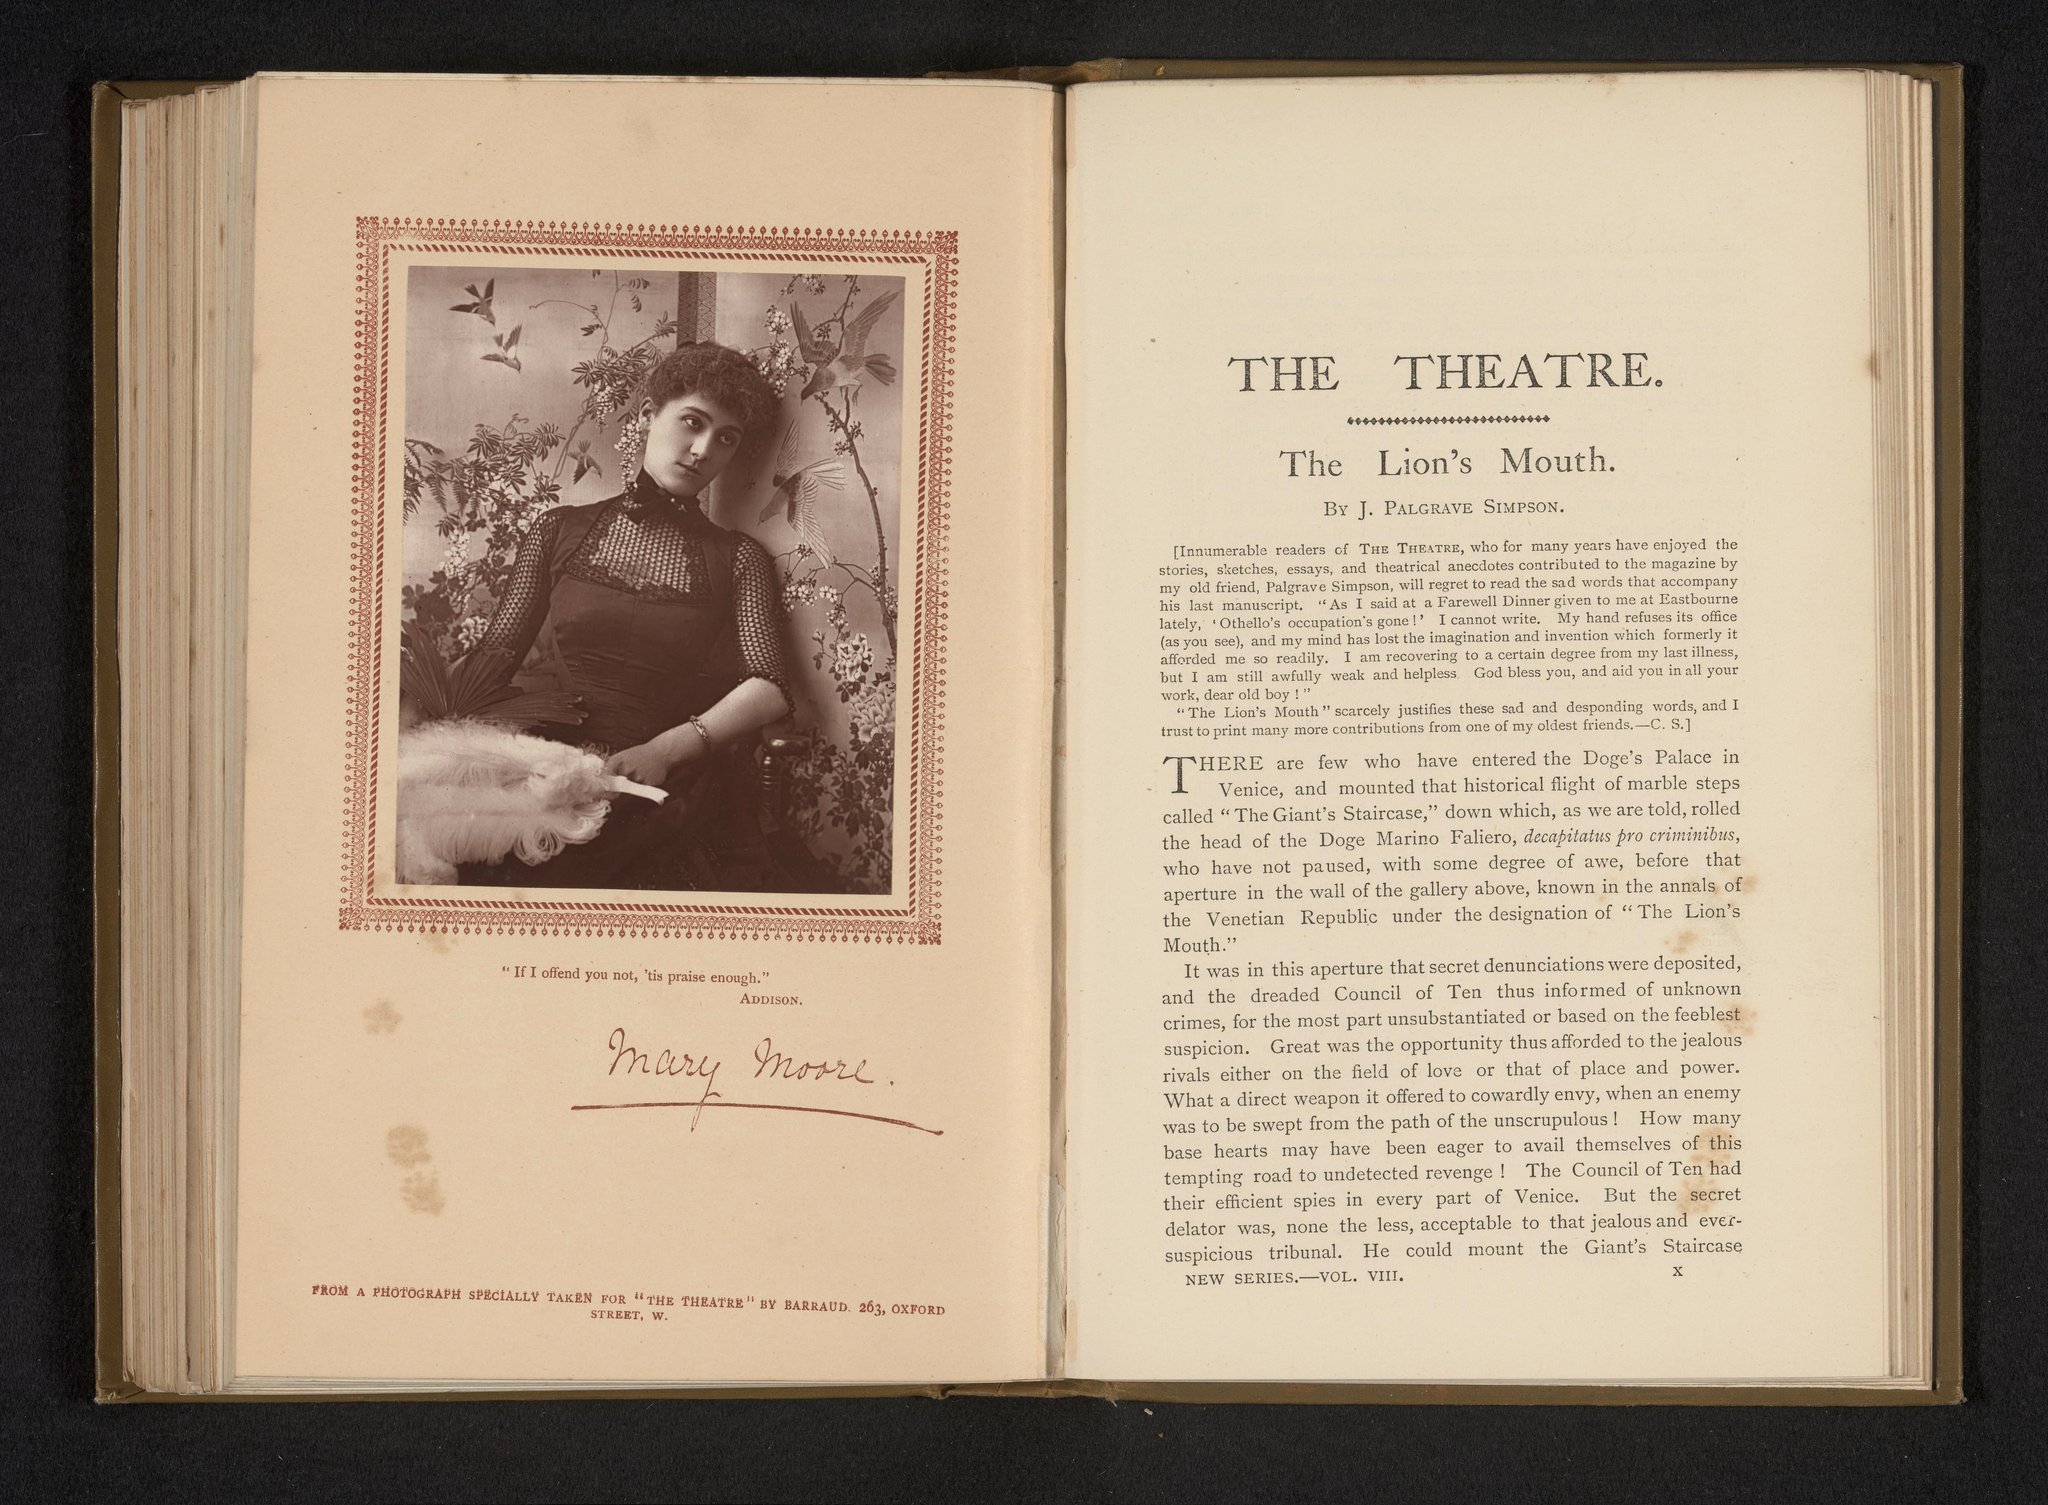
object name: photomechanical print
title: Portret van Mary Moore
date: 1881-1886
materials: paper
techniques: woodburytype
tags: adult woman, historical persons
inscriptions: signature: ‘Mary Moore’, inscription: ‘'If I offend you not, 'tis praise enough'/ Addison’